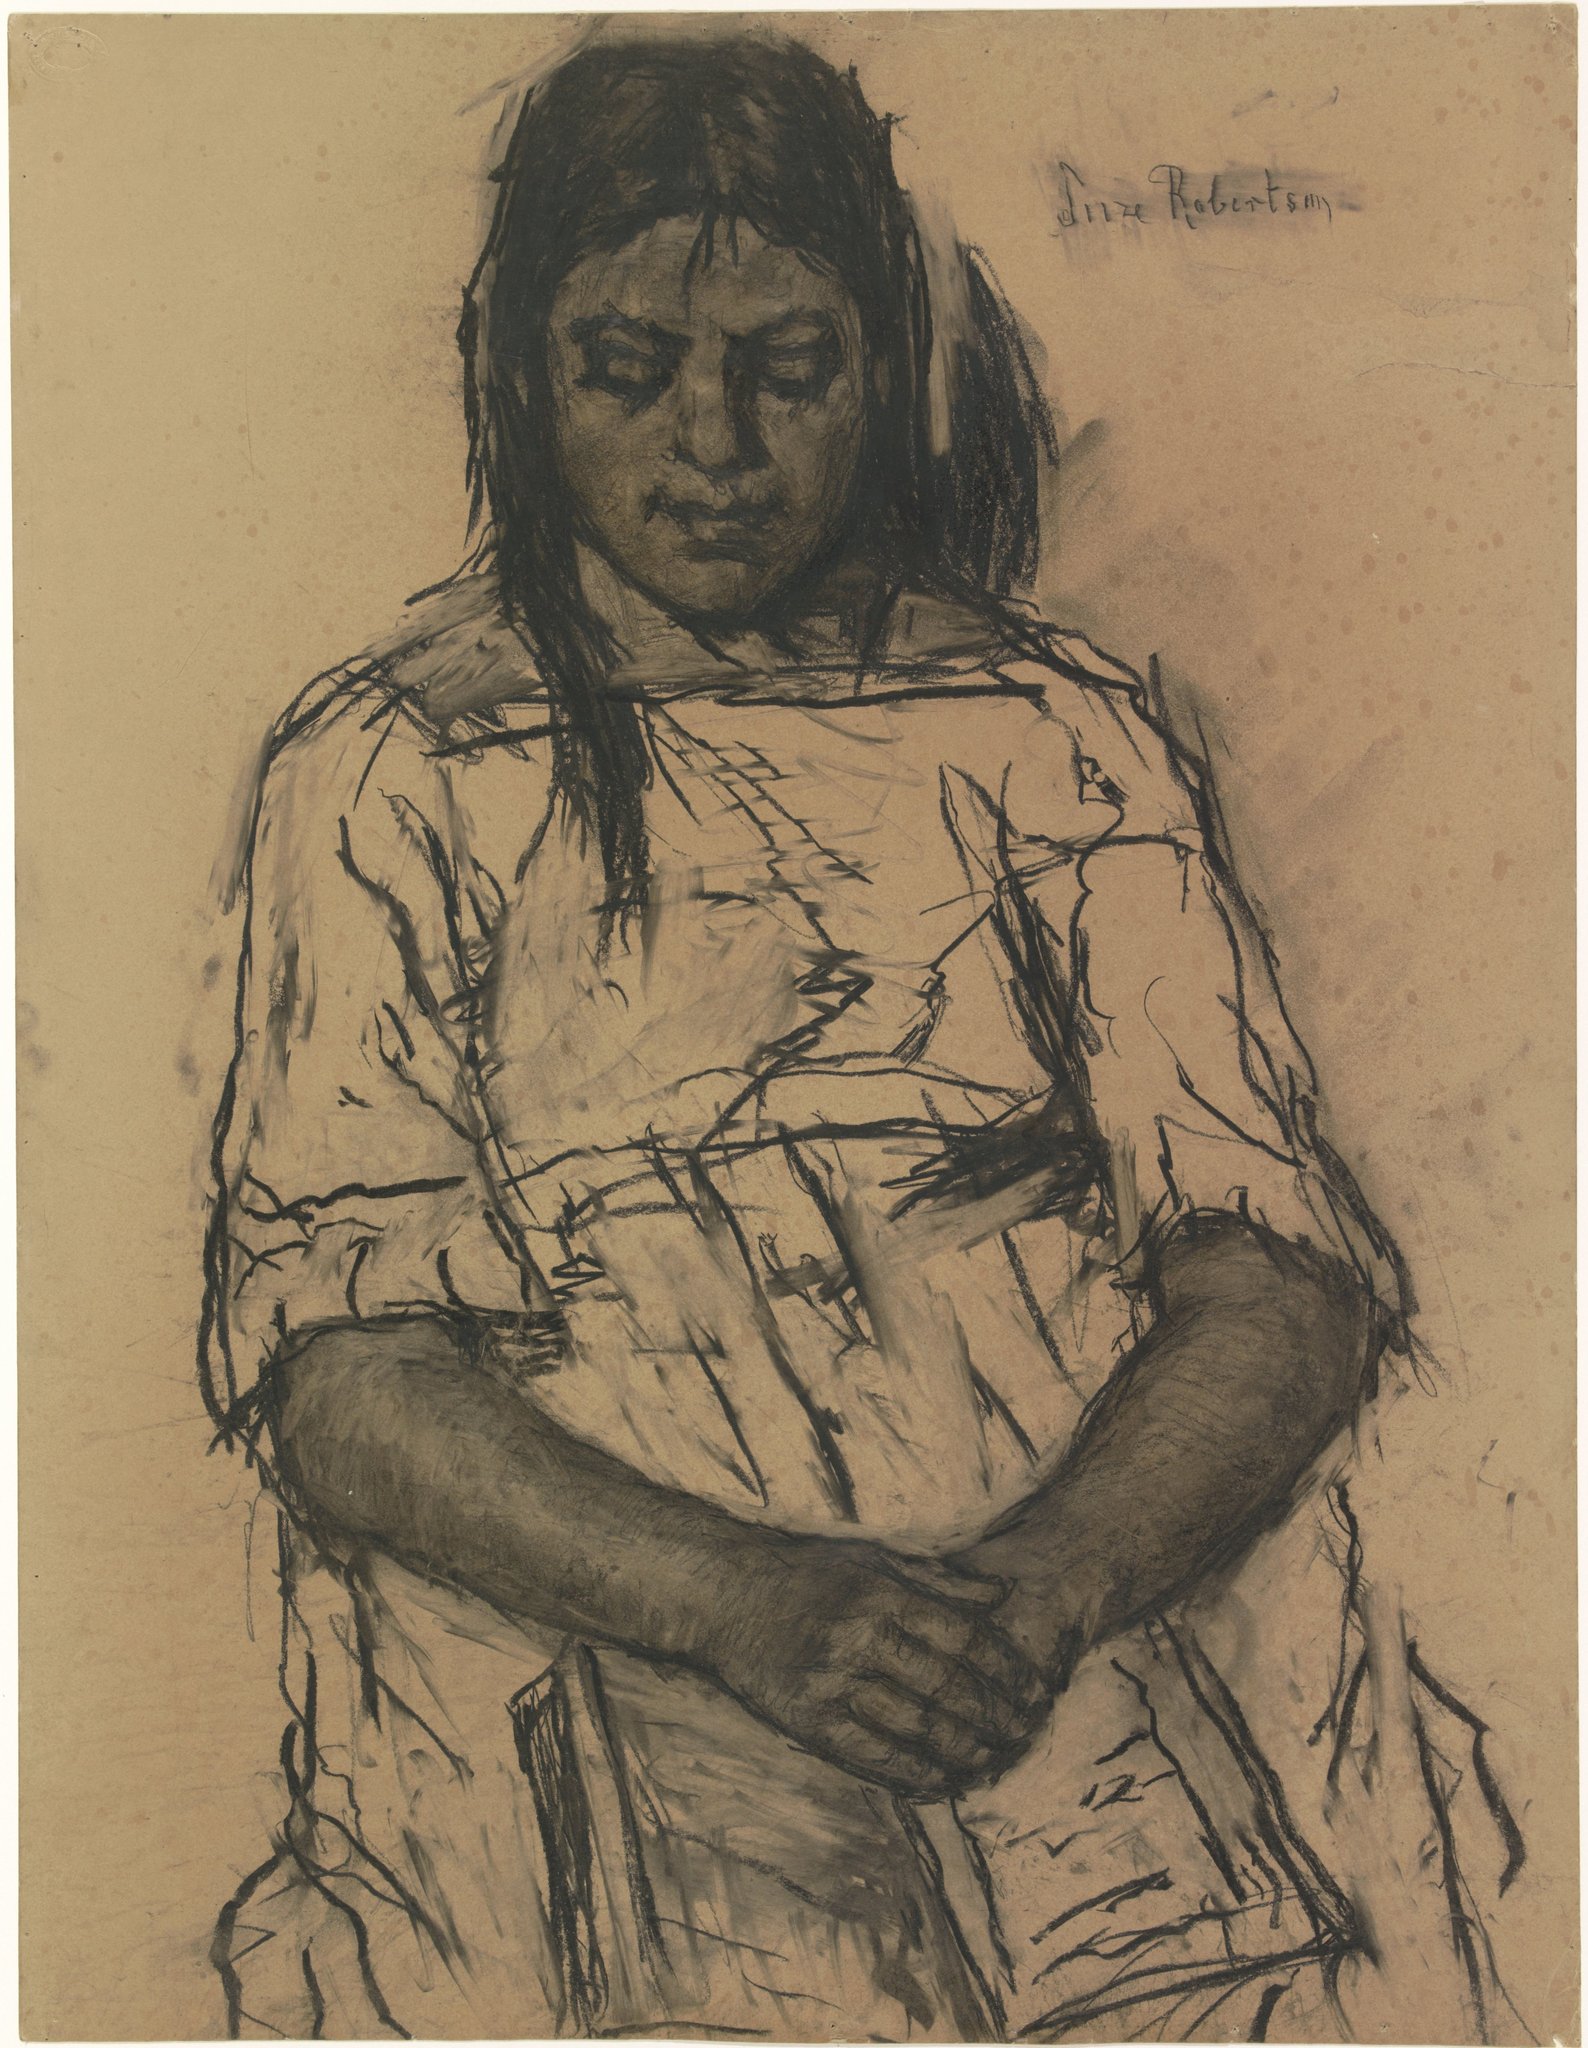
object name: drawing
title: Zittend meisje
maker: suze robertson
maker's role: draughtsman, painter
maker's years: 1855-1922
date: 1908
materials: chalk, paper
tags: rachel blik